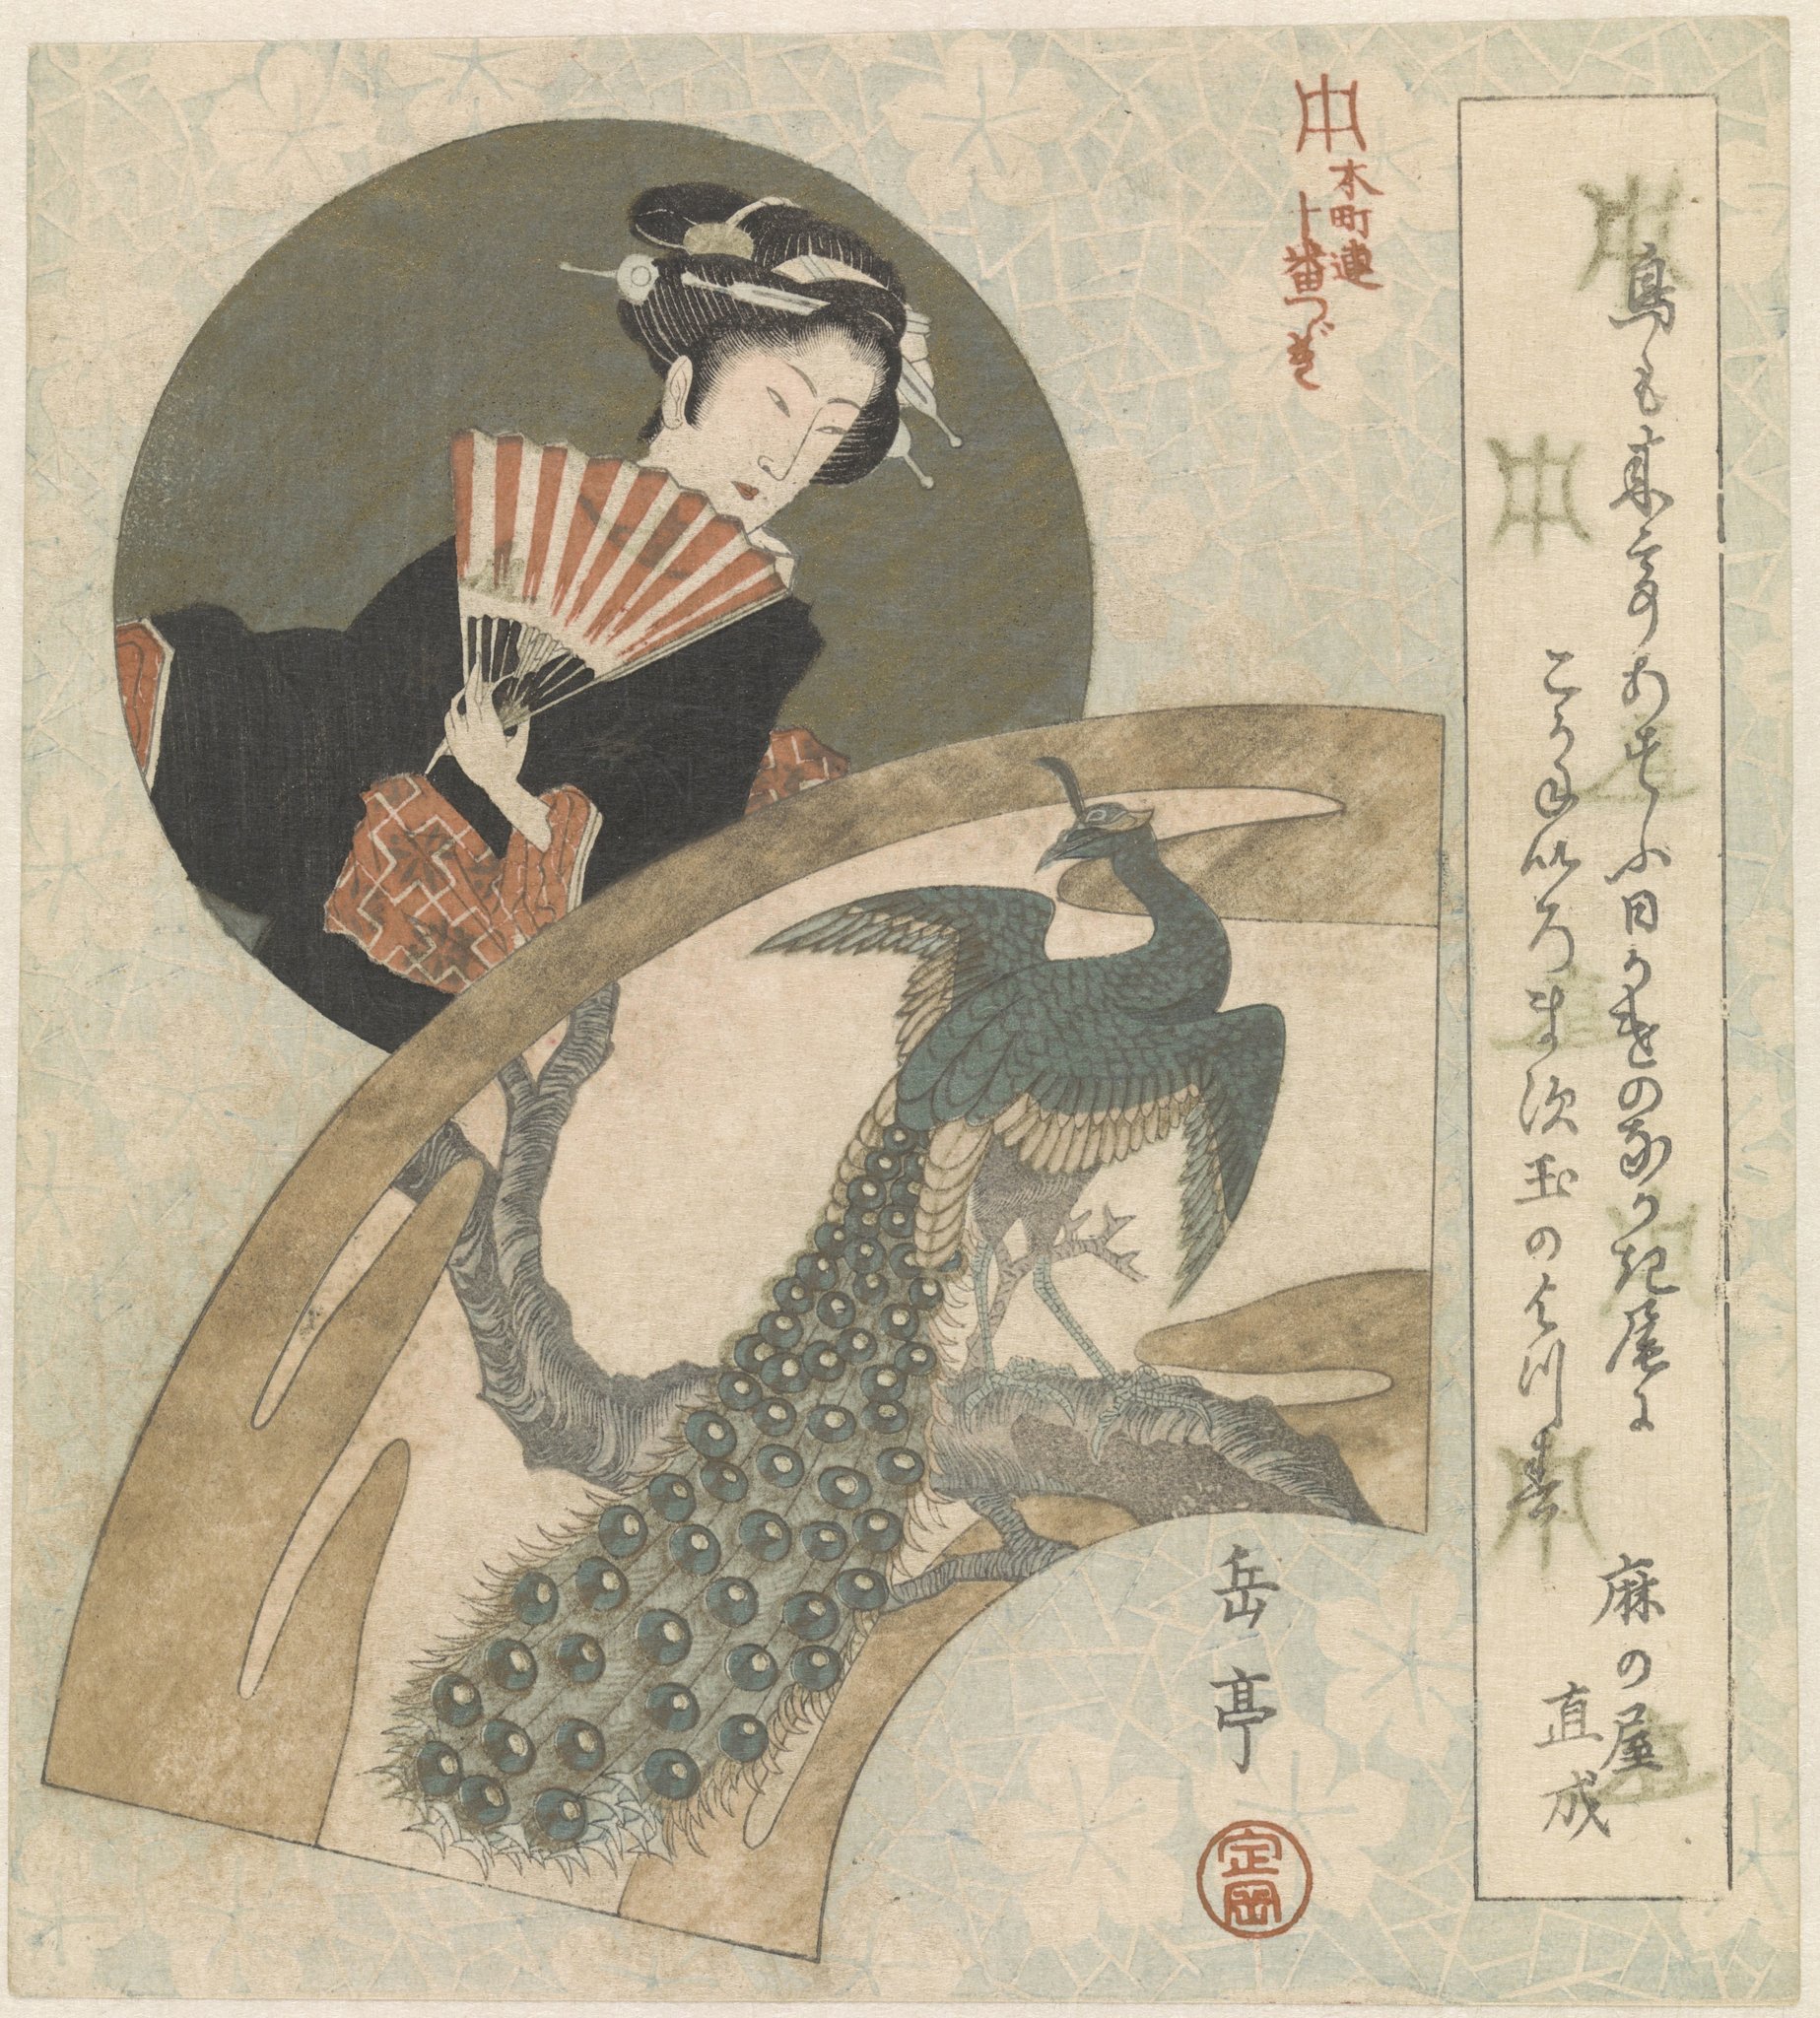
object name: surimono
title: Geisha and Peacock on Plum Tree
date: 1868-1912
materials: paper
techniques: blind stamped, woodcut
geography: japan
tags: ornamental birds: peacock, courtesan, hetaera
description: Een surimono is een luxe uitgevoerde prent waarop beeld met één of meerdere gedichten gecombineerd is. Bij het drukken van een surimono werd vaak gebruik gemaakt van dikker papier, blinddruk en metaal pigmenten, zoals koper- en zilverpoeder. De prenten werden vaak in opdracht van dichters gemaakt en als exclusief geschenk aan vrienden en relaties gegeven.